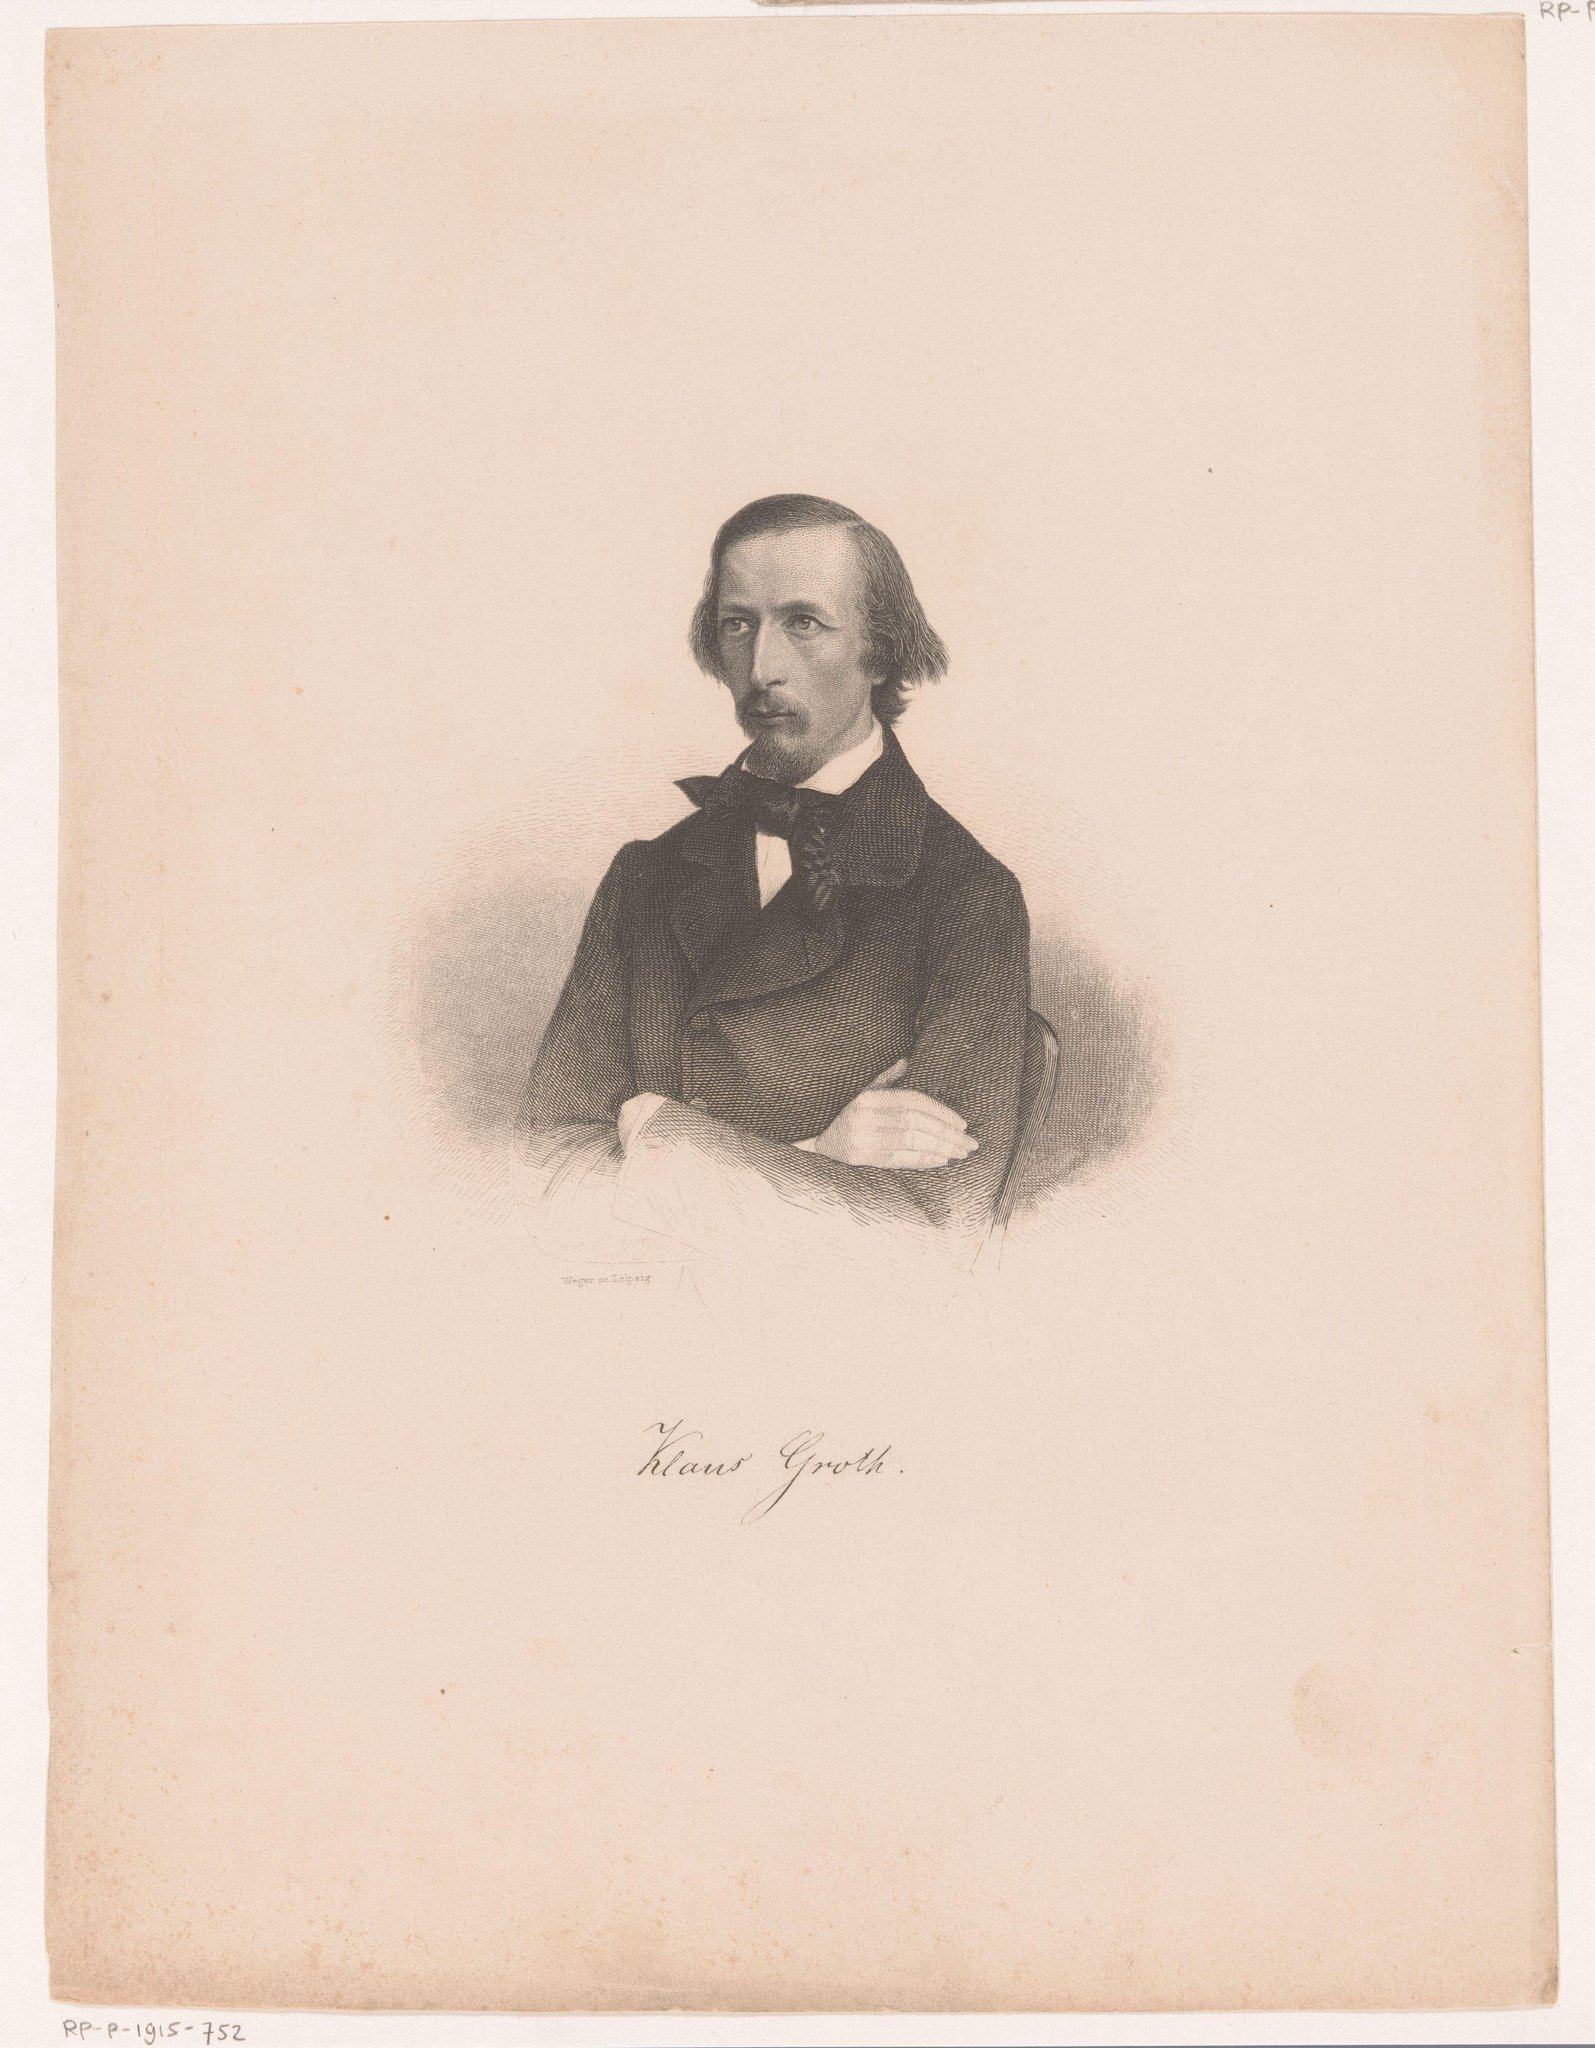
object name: print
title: Portret van Klaus Groth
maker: august weger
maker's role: print maker, printer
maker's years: 1823-1892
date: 1849-1892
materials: paper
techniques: engraving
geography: leipzig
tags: historical persons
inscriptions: collector's mark: Lugt 2228